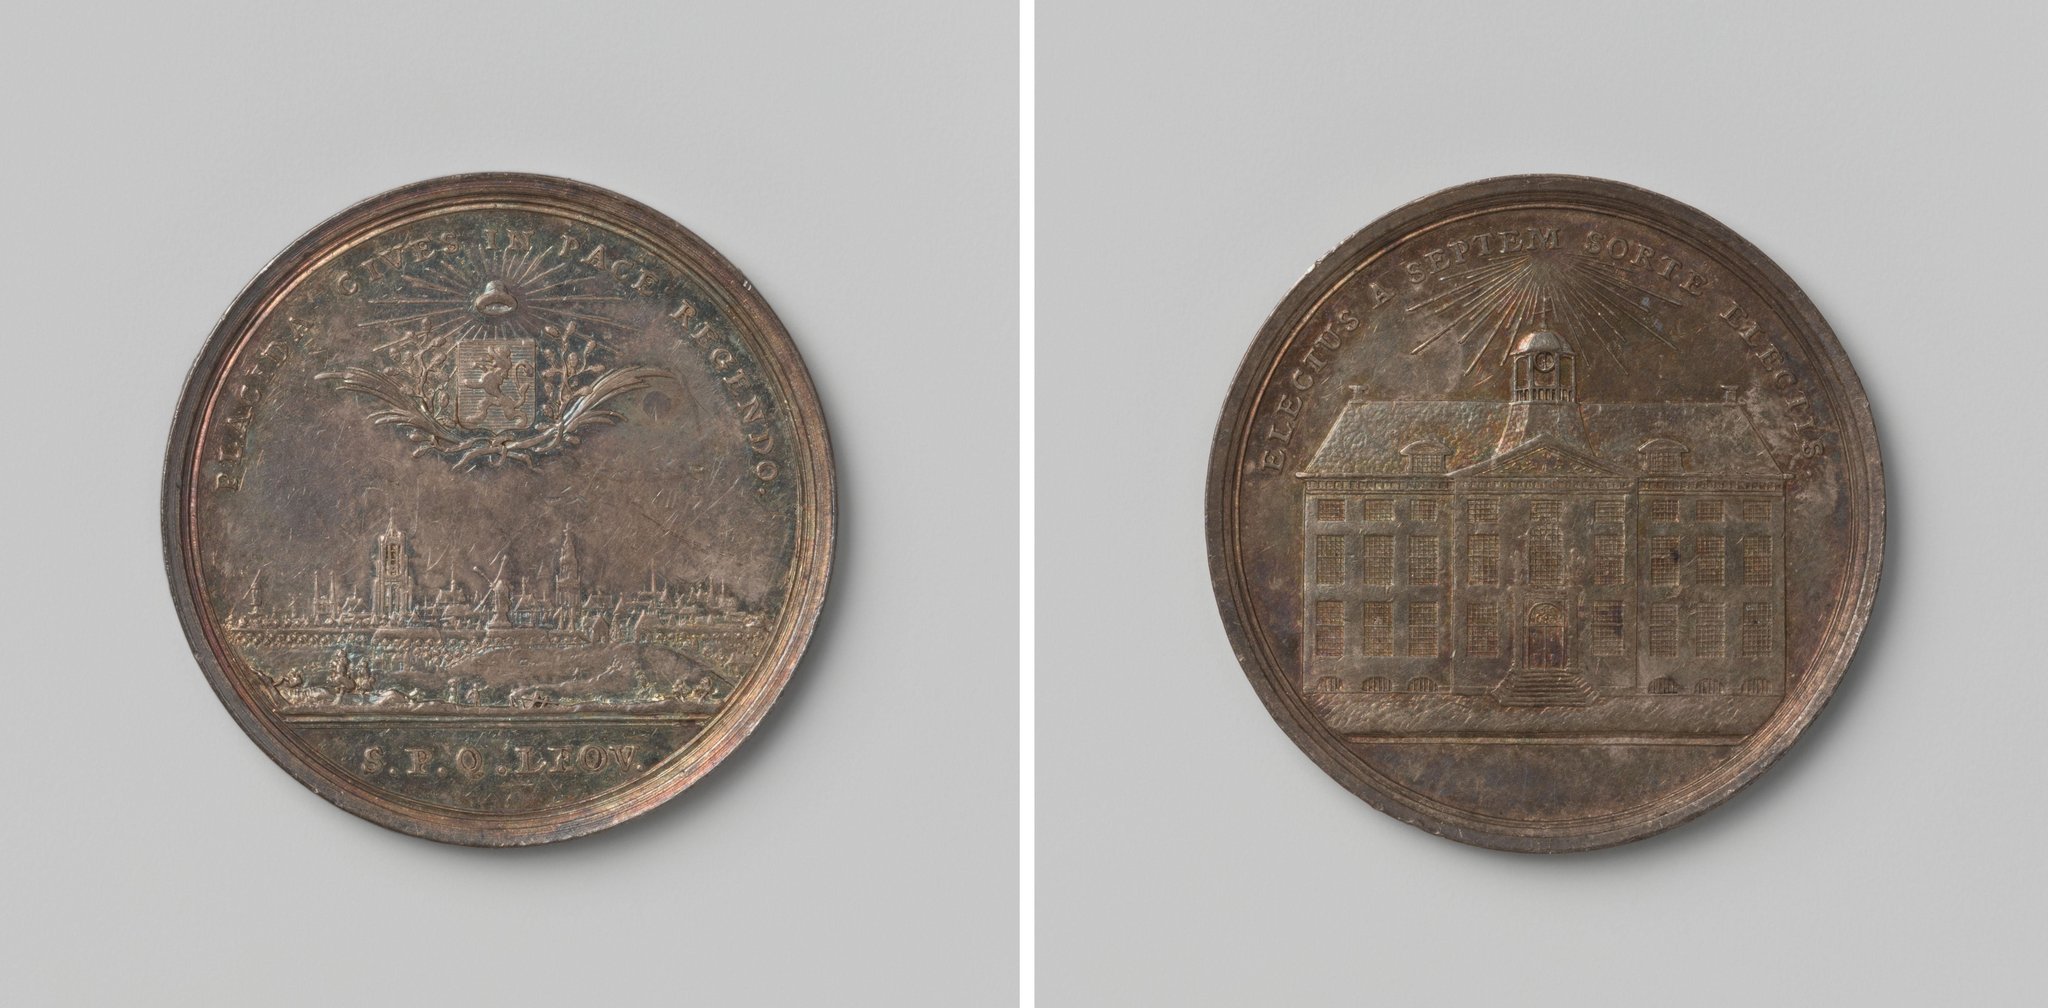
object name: council medal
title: Electiepenning van de stad Leeuwarden, penning voor de electeurs van vroedschapsleden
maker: johan george holtzhey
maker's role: mintmaster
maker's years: 1726-1808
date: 1786-1795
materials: silver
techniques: striking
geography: amsterdam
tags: leeuwarden